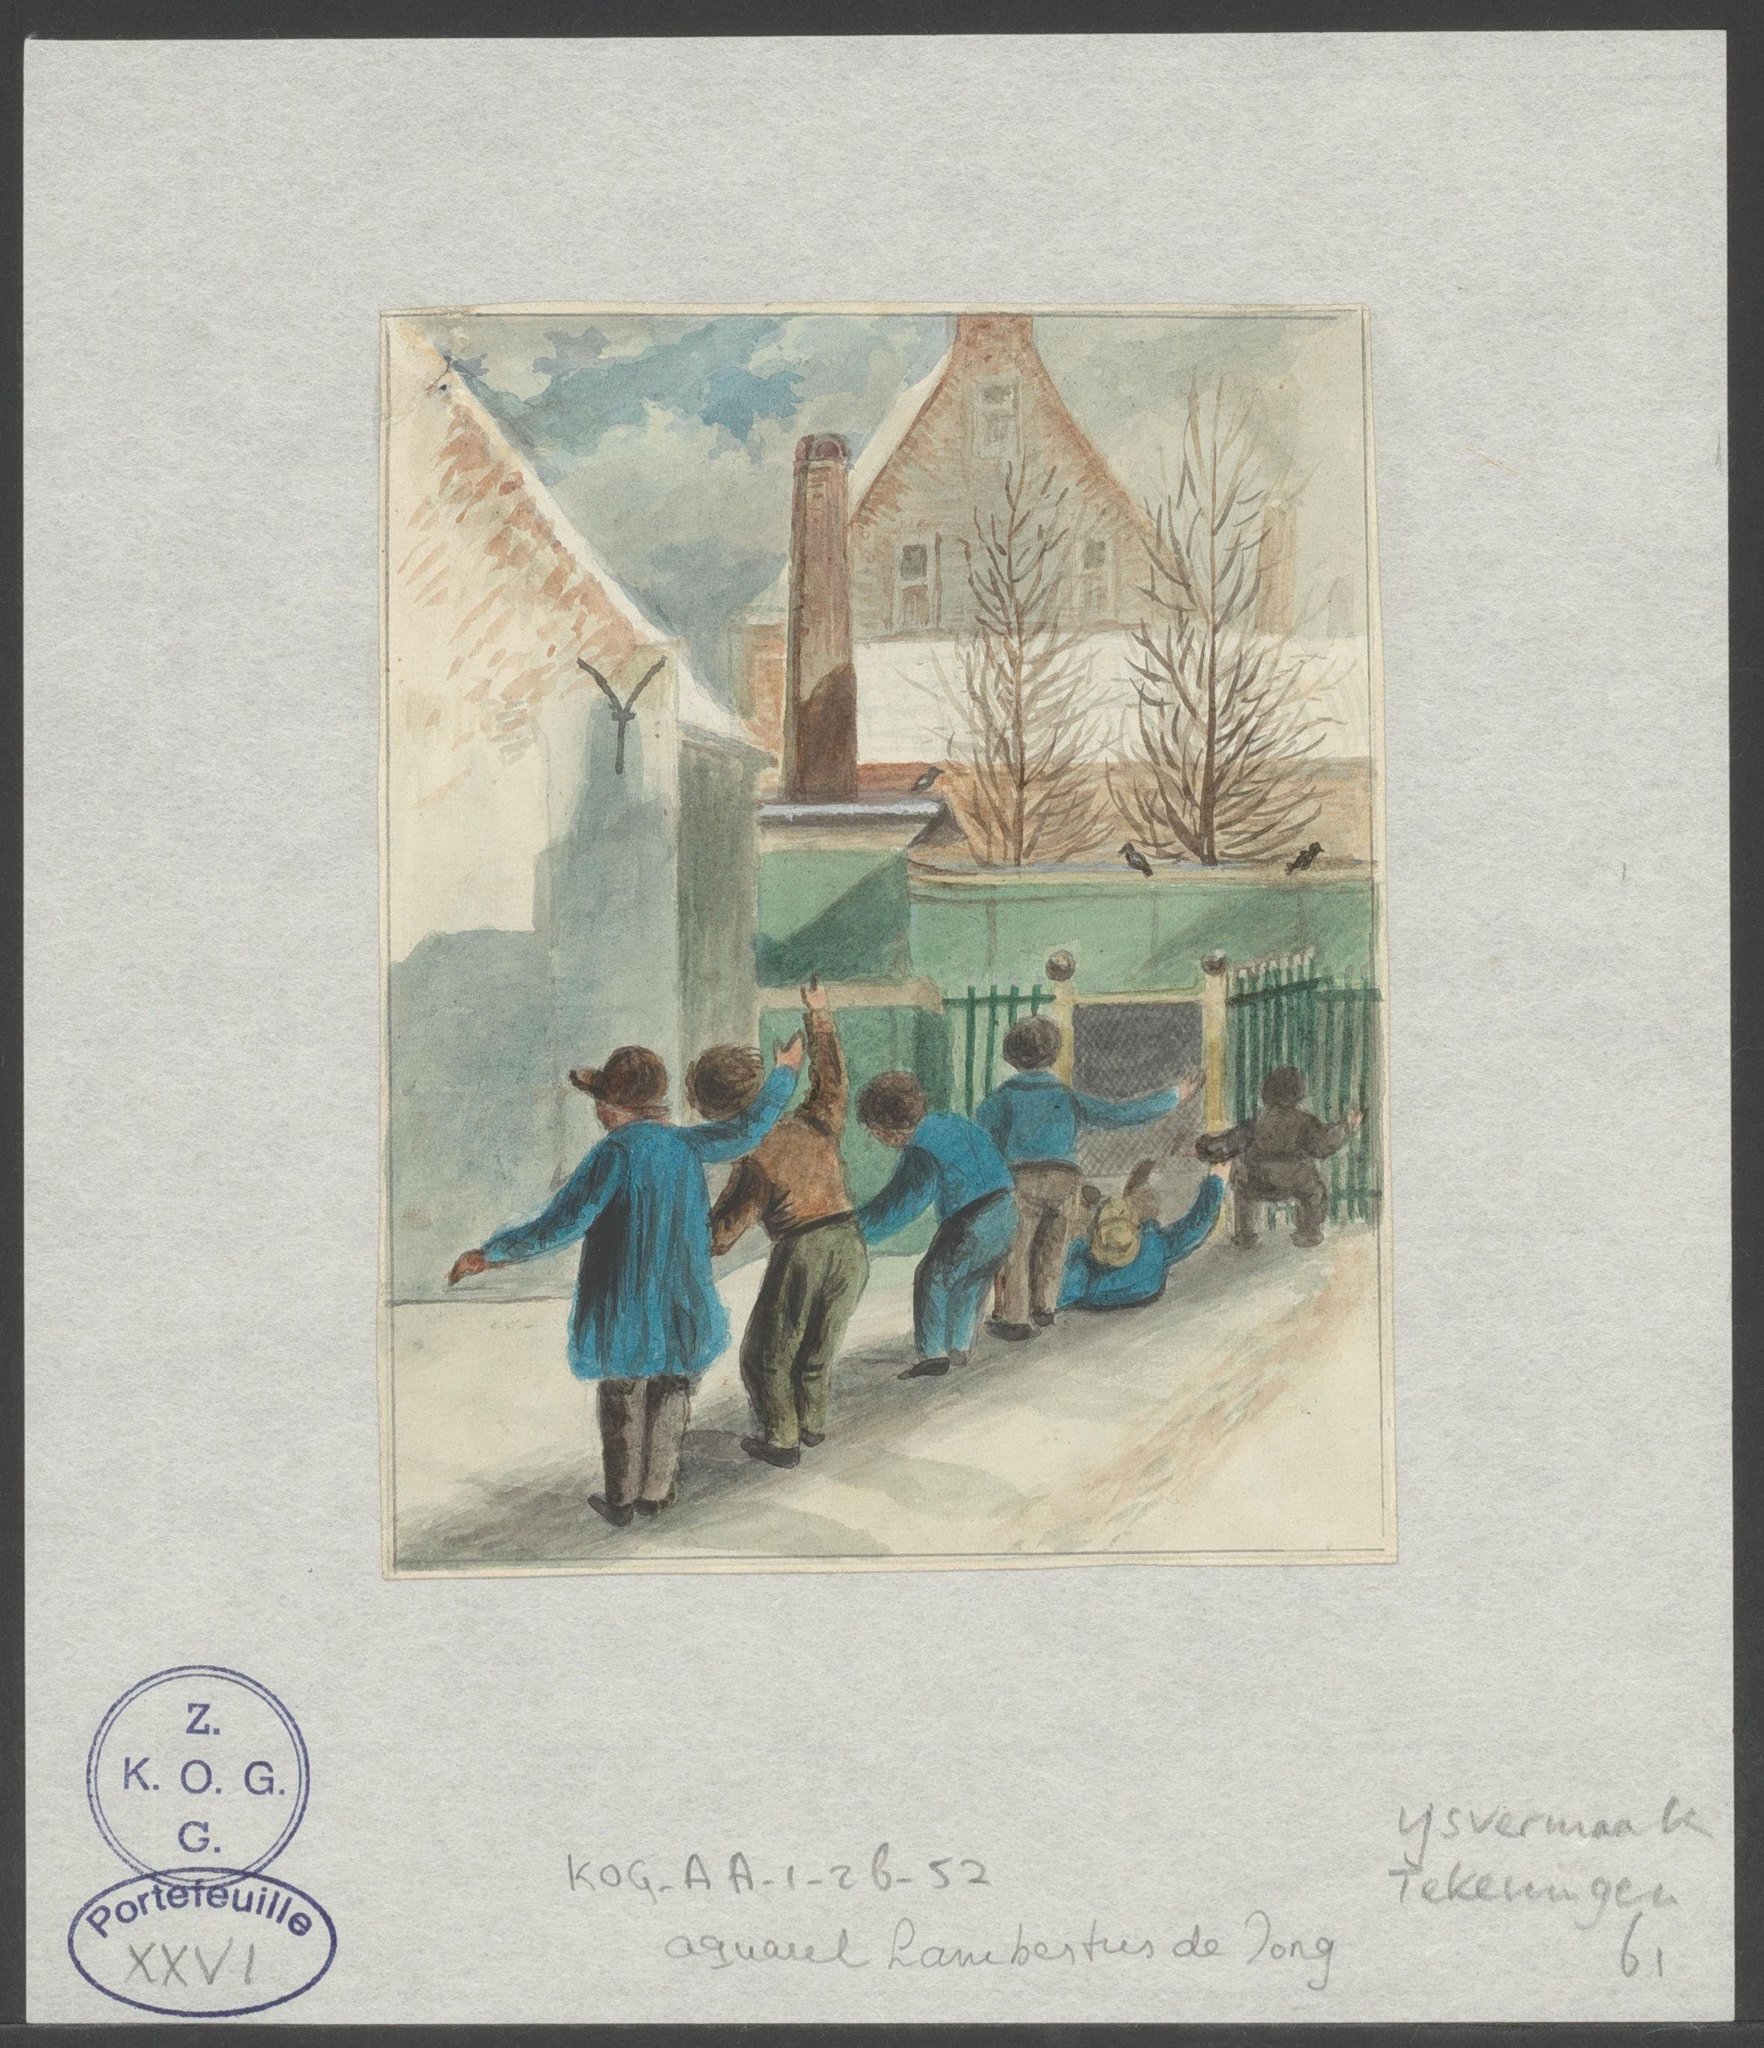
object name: drawing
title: Kinderen op een glijbaan in de sneeuw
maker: lambertus de jong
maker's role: bakker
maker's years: 1838-1923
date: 1854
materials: paper, watercolor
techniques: brush, pen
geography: netherlands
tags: children's games and plays, winter sports, slipping, ice ~ freezing weather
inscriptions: collector's mark: Lugt 1641, collector's mark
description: Kinderen glijden op een glijbaantje gemaakt in de sneeuw op de stoep. Onderwerpsrubrieken binnen de Atlas Zeden en Gewoonten: Spel en Vermaak; IJsvermaak, Teekeningen.